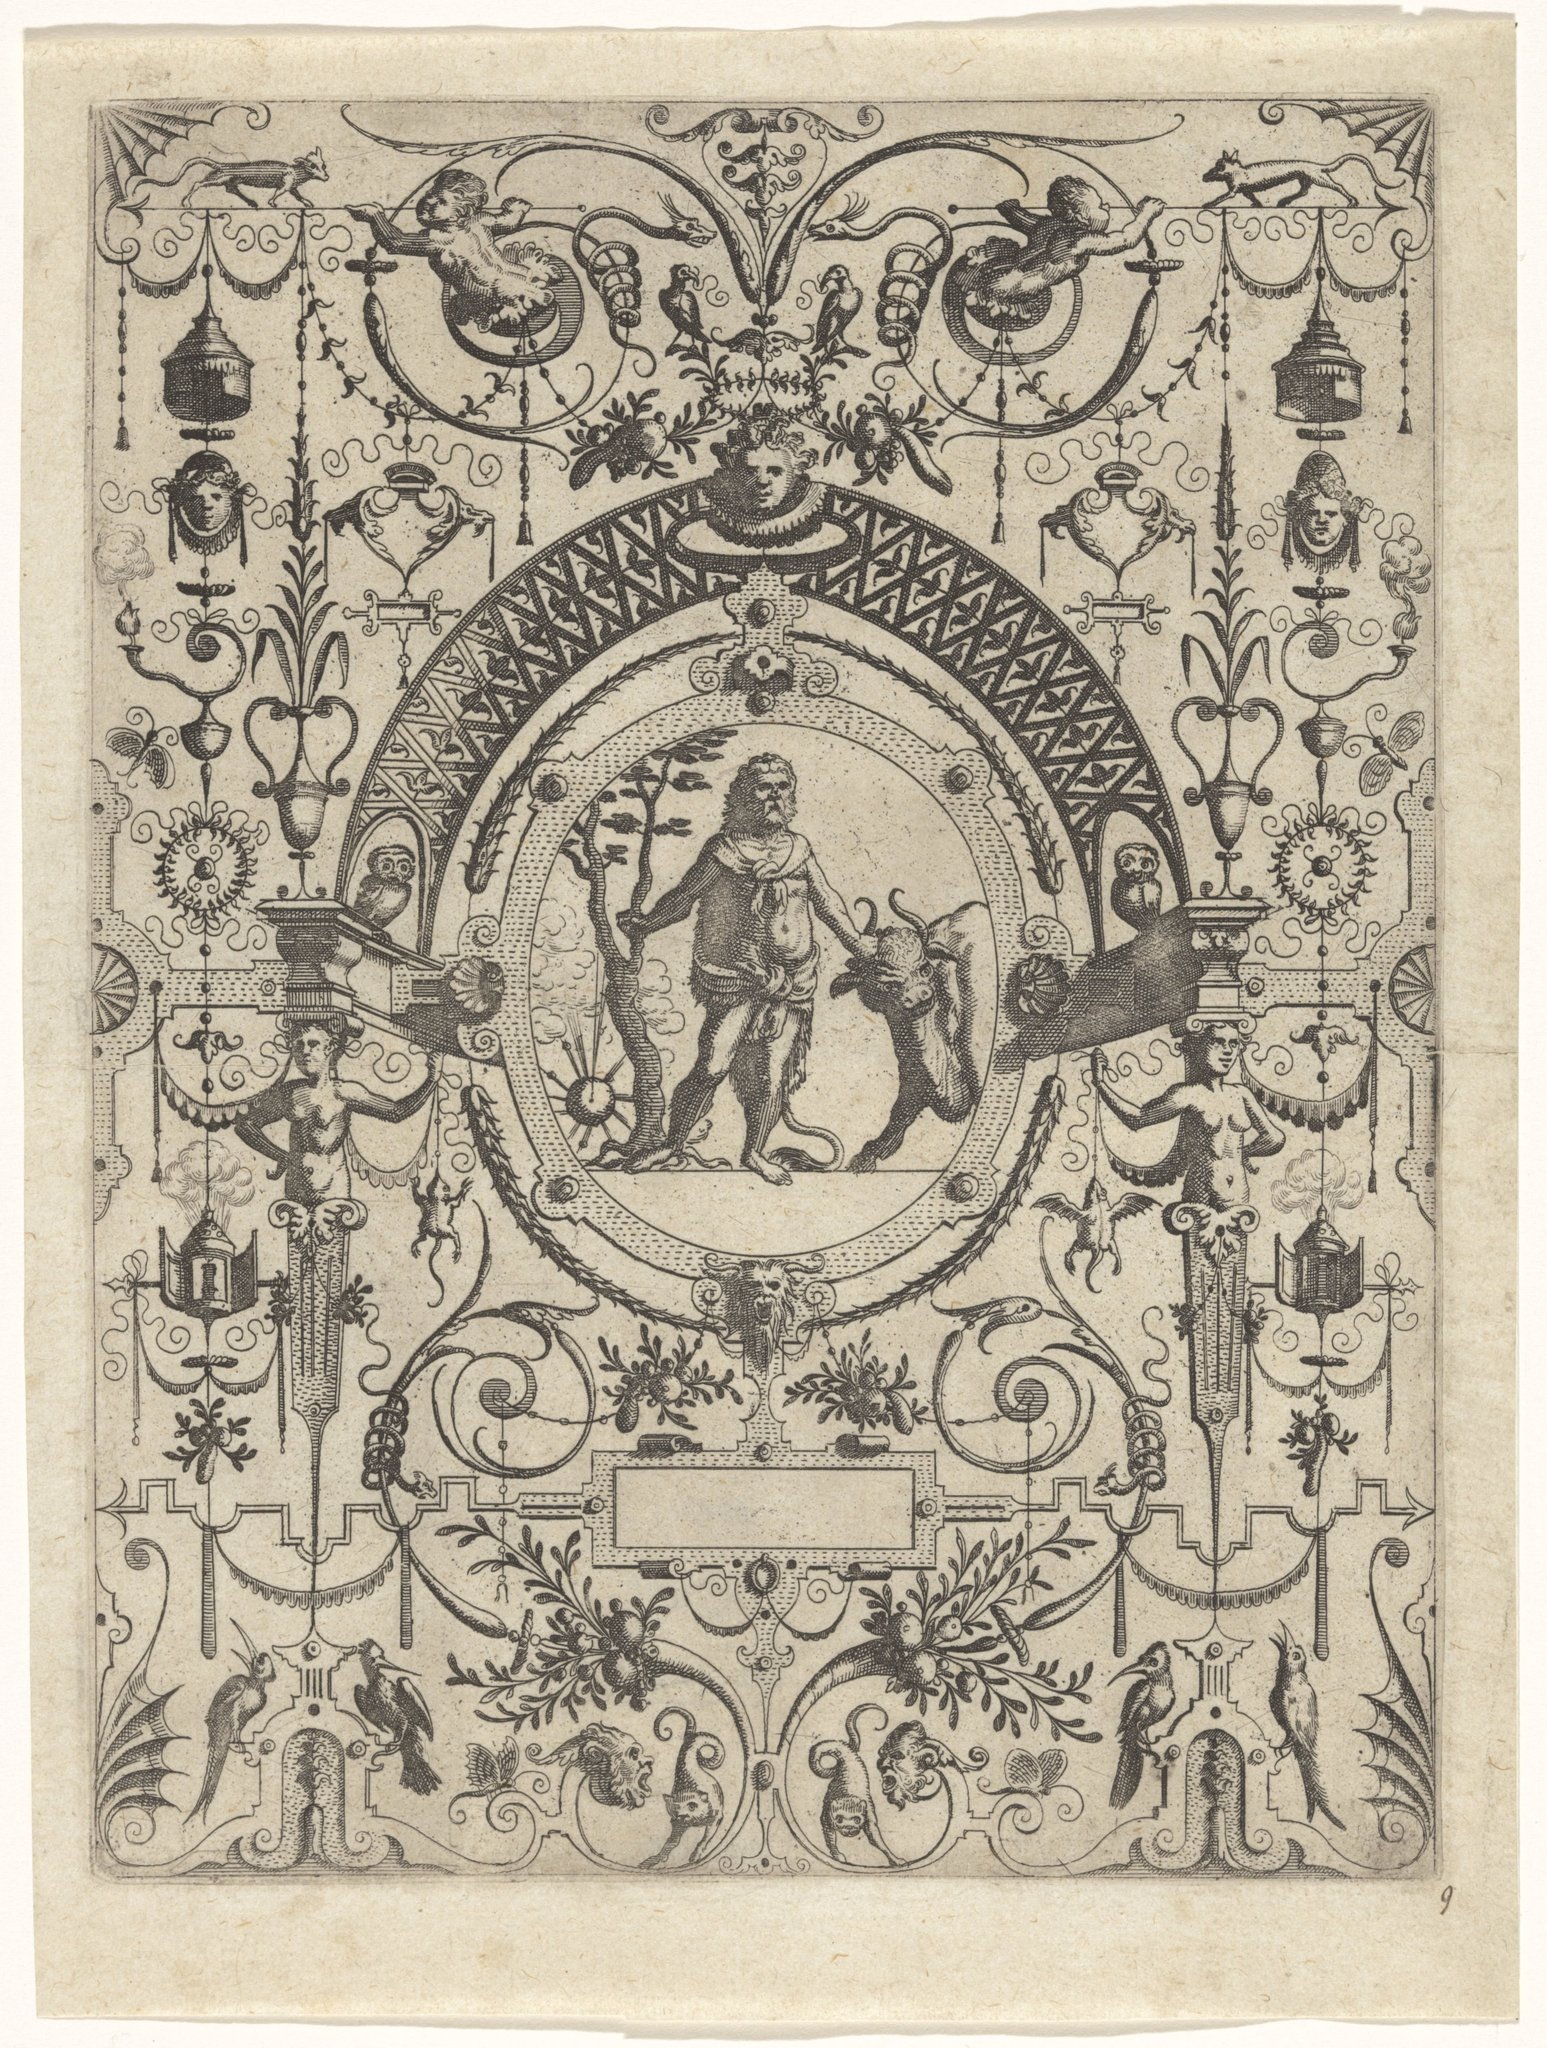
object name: ornament print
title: Grottesco: in diversche manieren (...)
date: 1565-1571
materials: paper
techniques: etching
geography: netherlands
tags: (7) the cretan bull is captured by hercules, ornament ~ cartouche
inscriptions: number: ‘9’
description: Hercules, staand naast een boom, de Kretenzische stier met zijn linkerhand vasthoudend. Over de cartouche heen loopt een boog, gedecoreerd met bladmotieven, die wordt gedragen door twee vrouwelijke hermen. Uit serie van titelblad + 16 bladen met cartouches of architectuurfantasieën met een voorstelling in een omlijsting van grotesken met fabelwezens, dieren, guirlandes, trofeeën en mascarons.